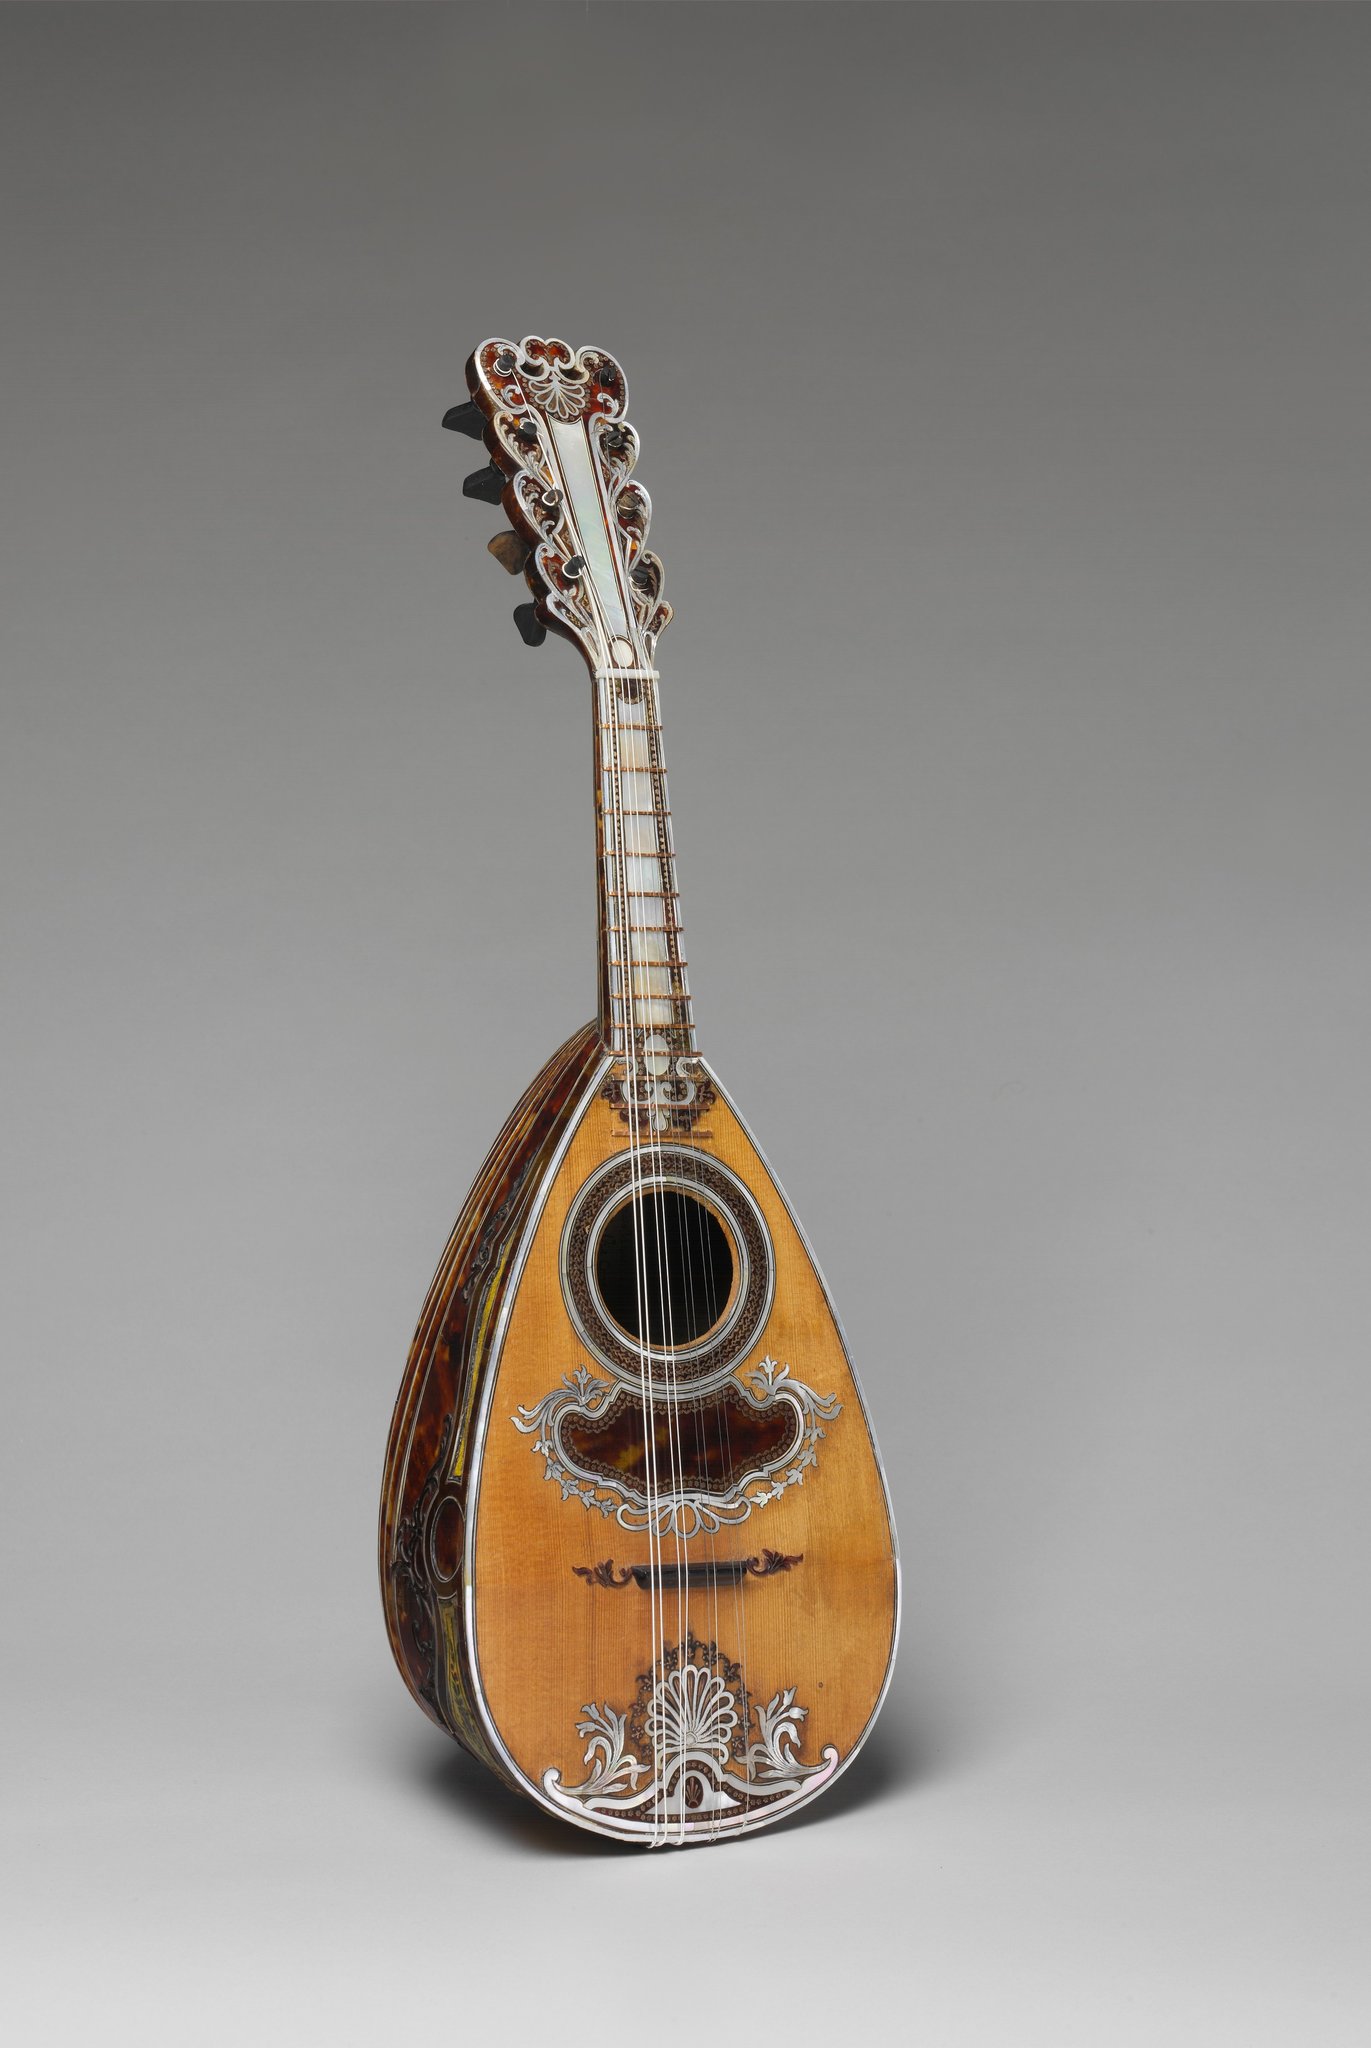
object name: mandolin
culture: italian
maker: antonius vinaccia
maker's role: maker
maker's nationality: italian, naples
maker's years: 1754-1781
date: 1781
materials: alloy, gold, ivory, mother of pearl, wood, shell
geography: italy